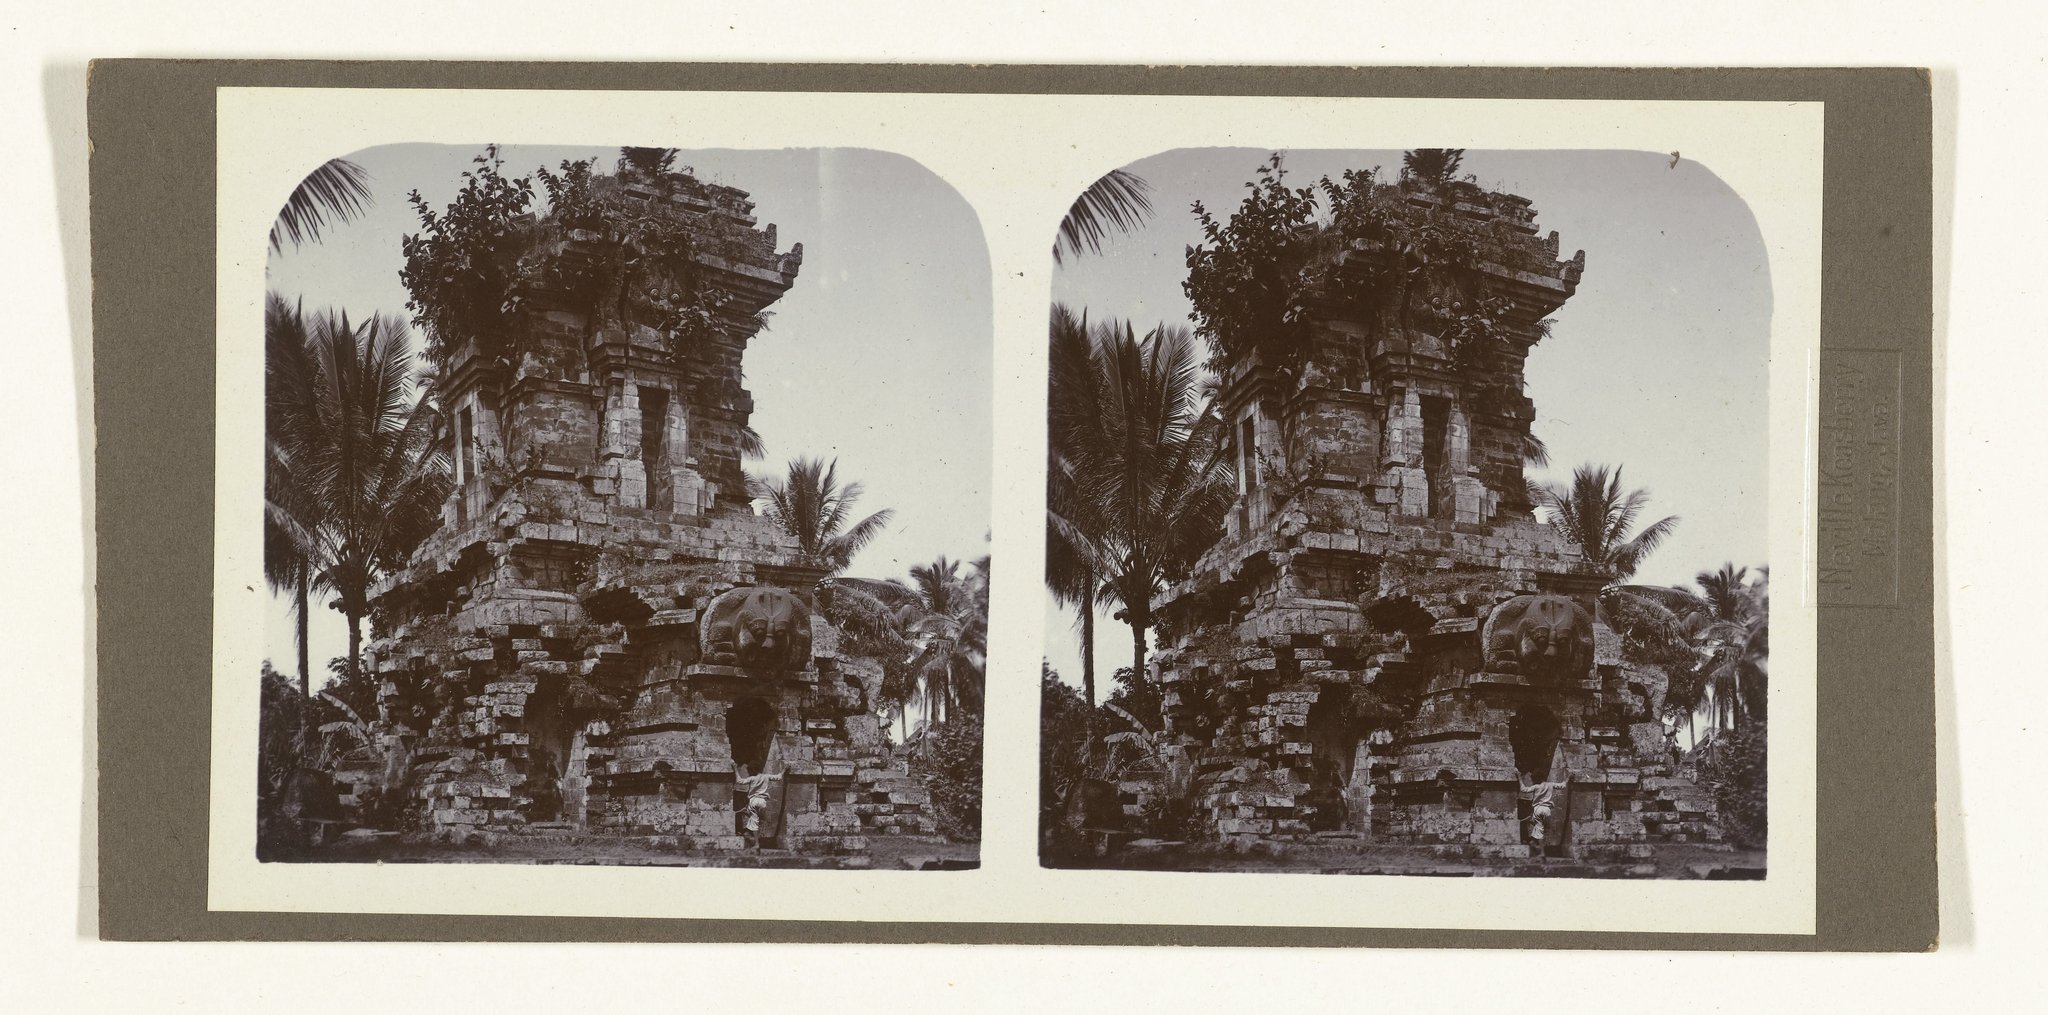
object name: stereograph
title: S 1 No 12. De Hindoetempel te Singosarie.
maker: neville keasberry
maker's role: fotograaf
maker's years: 1866-1944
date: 1900-1935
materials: cardboard, paper, photographic support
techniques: albumen print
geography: malang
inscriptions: signature: ‘Neville Keasberry, Malang (Java)’, title: ‘S 1 No 12. De Hindoetempel te Singosarie.’